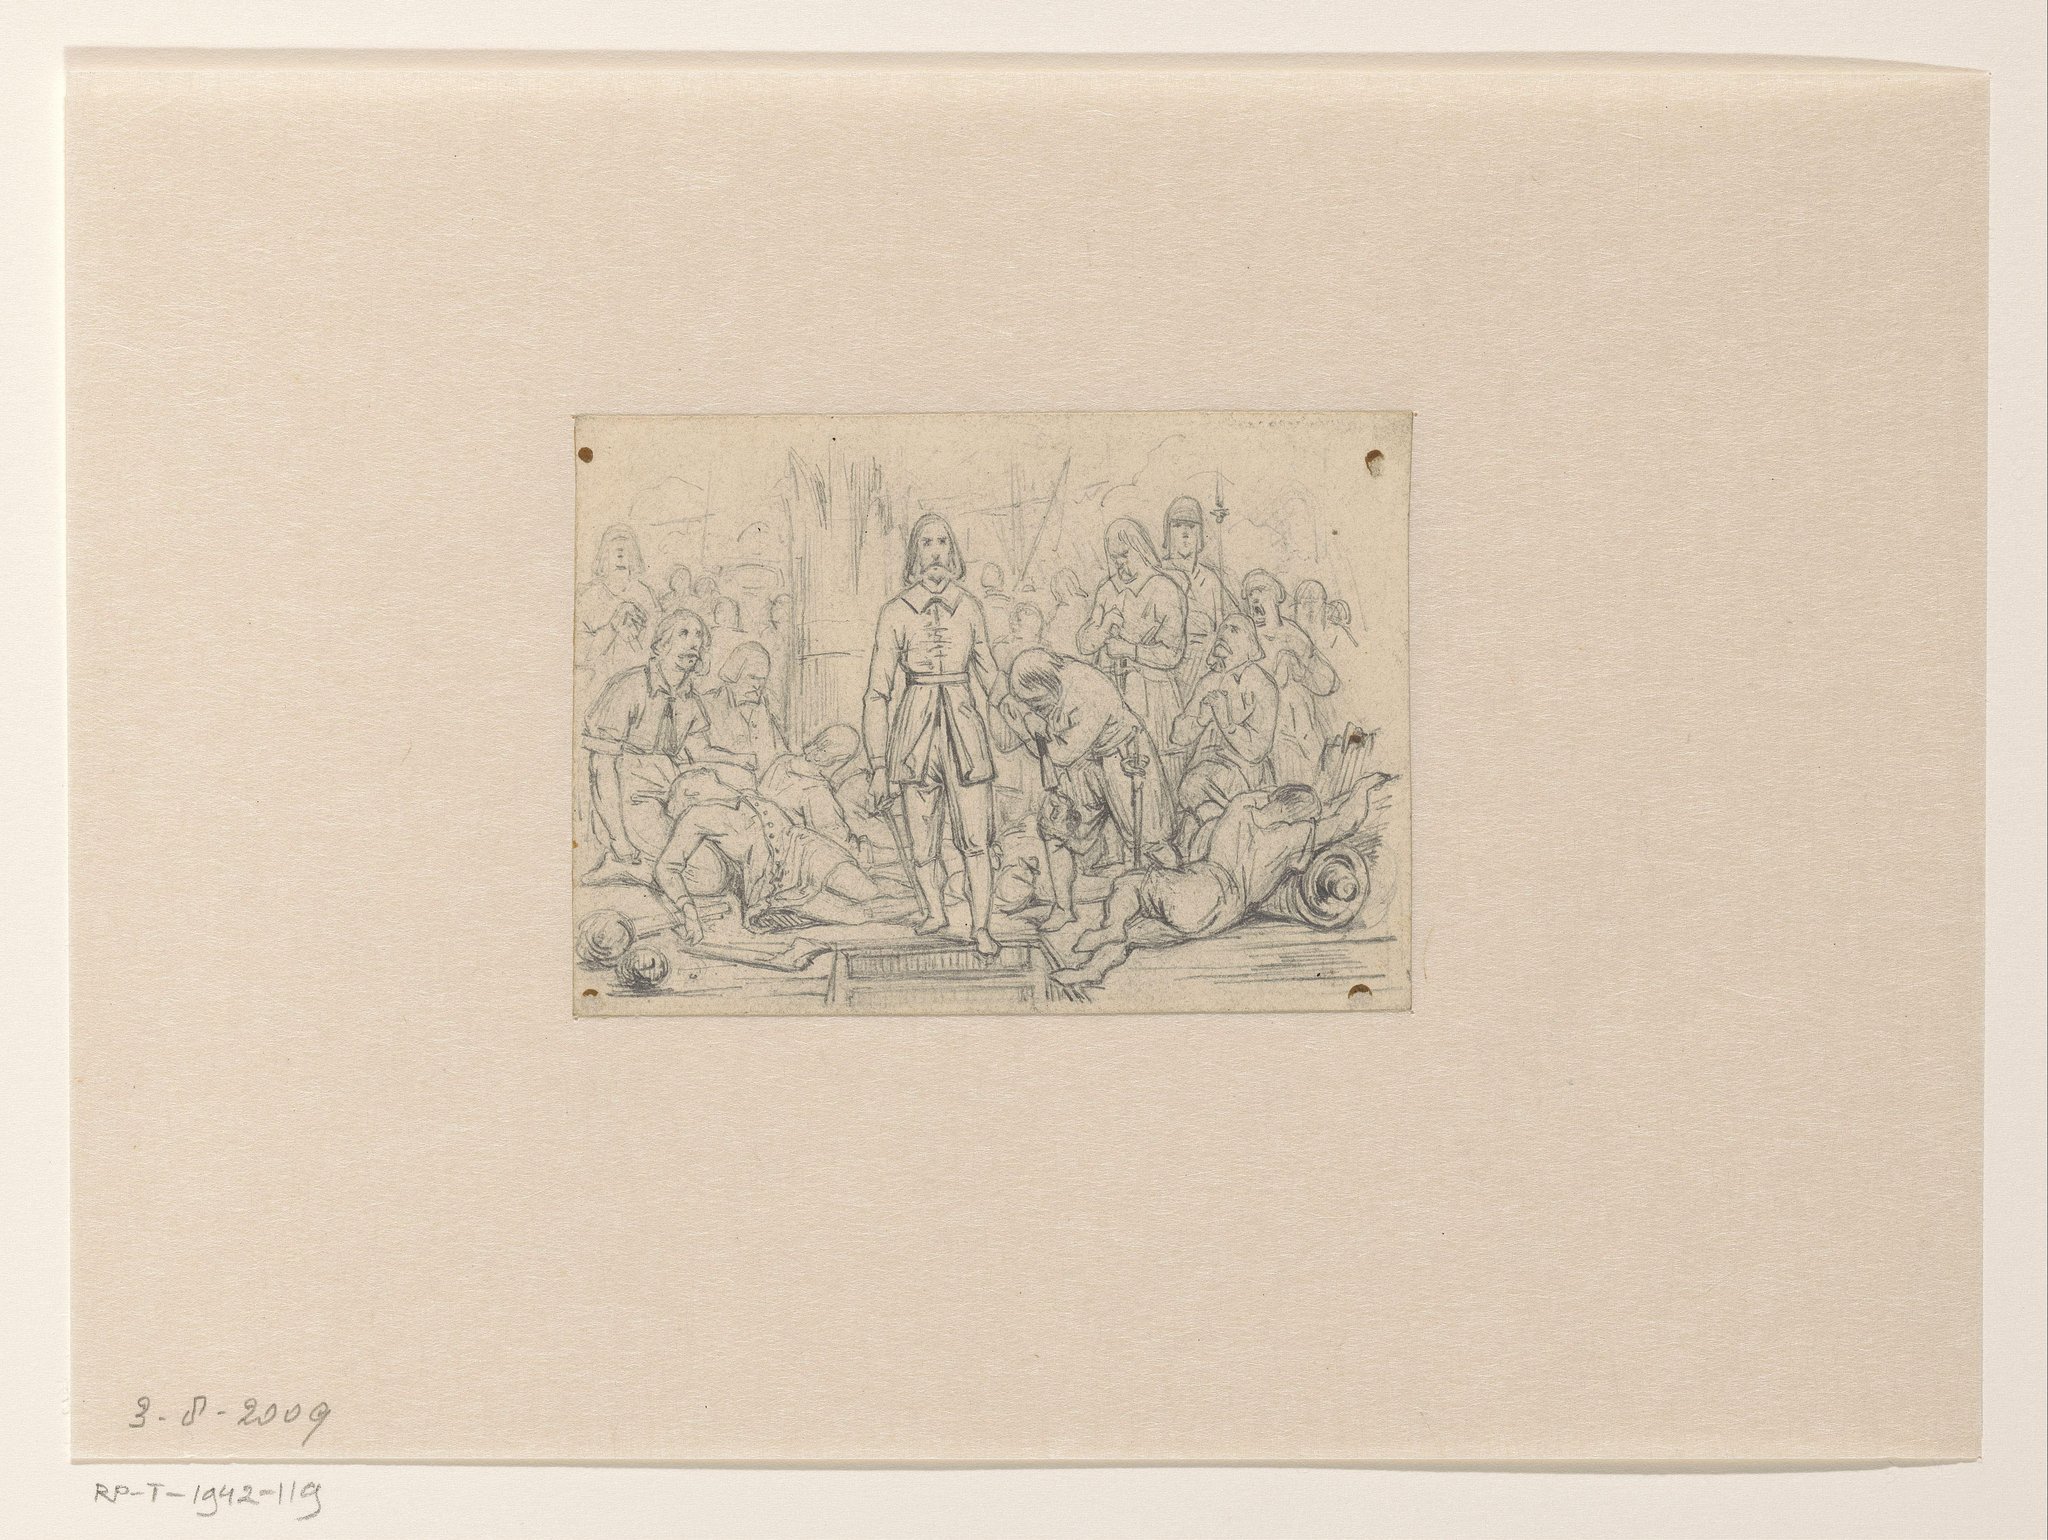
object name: drawing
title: Man die op het punt staat een trap af te dalen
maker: edouard taurel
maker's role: draughtsman, print maker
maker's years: 1824-1892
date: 1834-1892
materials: paper, pencil